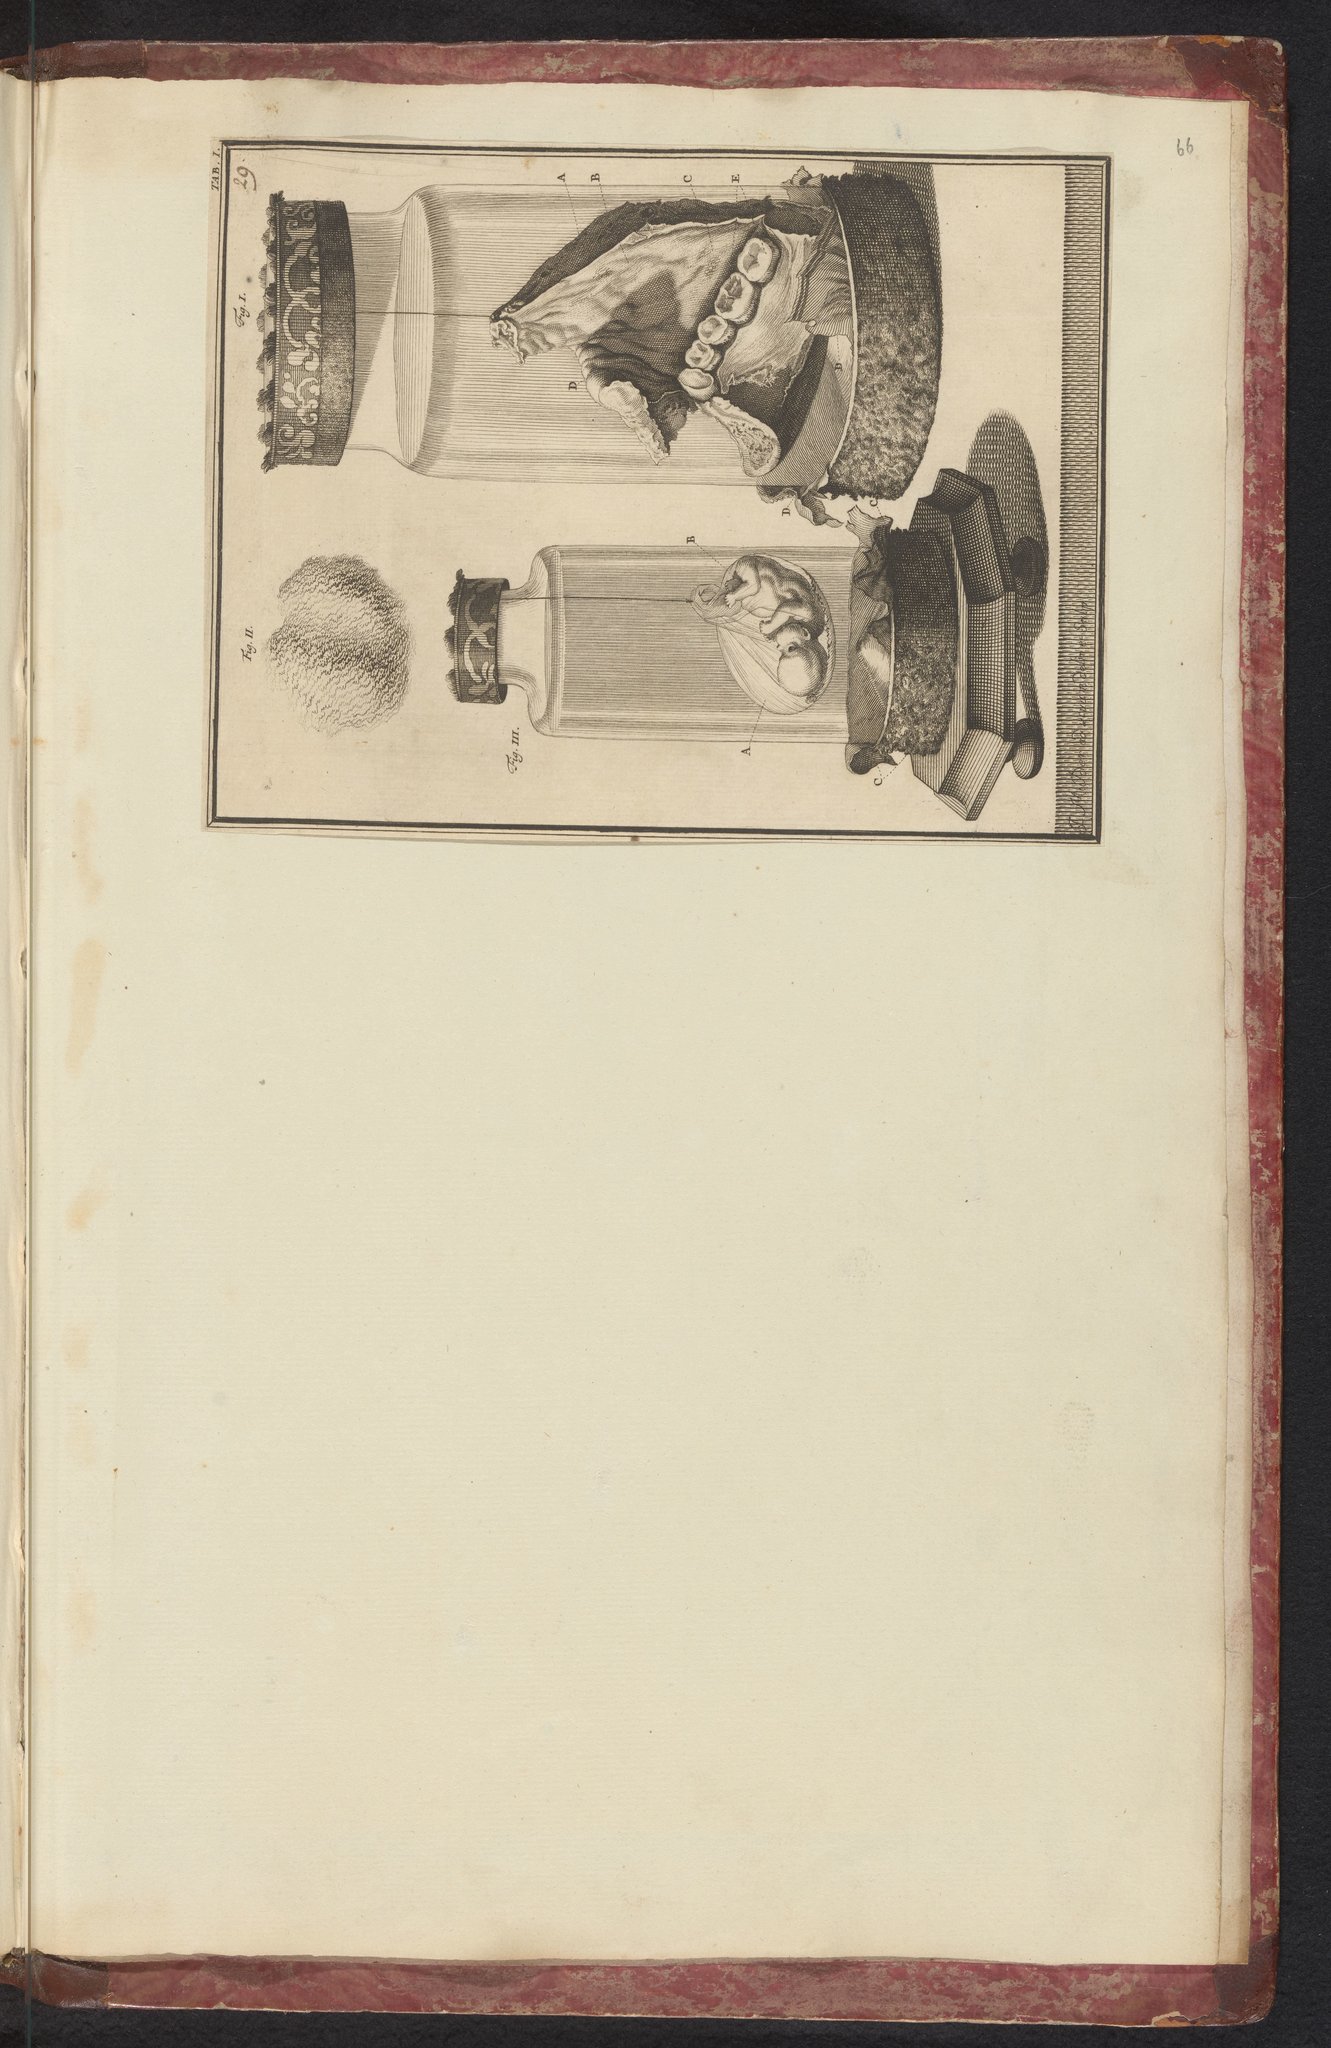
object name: print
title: Anatomische preparaten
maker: joseph mulder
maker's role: print maker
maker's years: 1658-1718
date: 1714-1716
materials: paper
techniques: engraving, etching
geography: amsterdam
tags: frederik ruysch, anatomical specimen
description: Ingeplakte prent met anatomische preparaten van Frederik Ruysch, in potten op sterk water, figs I-III. Rechtsboven: Tab. I en handgenummerd: 29. Onderdeel van het zevende album met tekeningen van reptielen, amfibieën en natuurhistorische ensembles. Het zevende van twaalf albums met aquarellen van dieren, vogels en planten bekend rond 1600, gemaakt in opdracht van keizer Rudolf II. Met toelichting in Nederlands, Latijn en Frans.